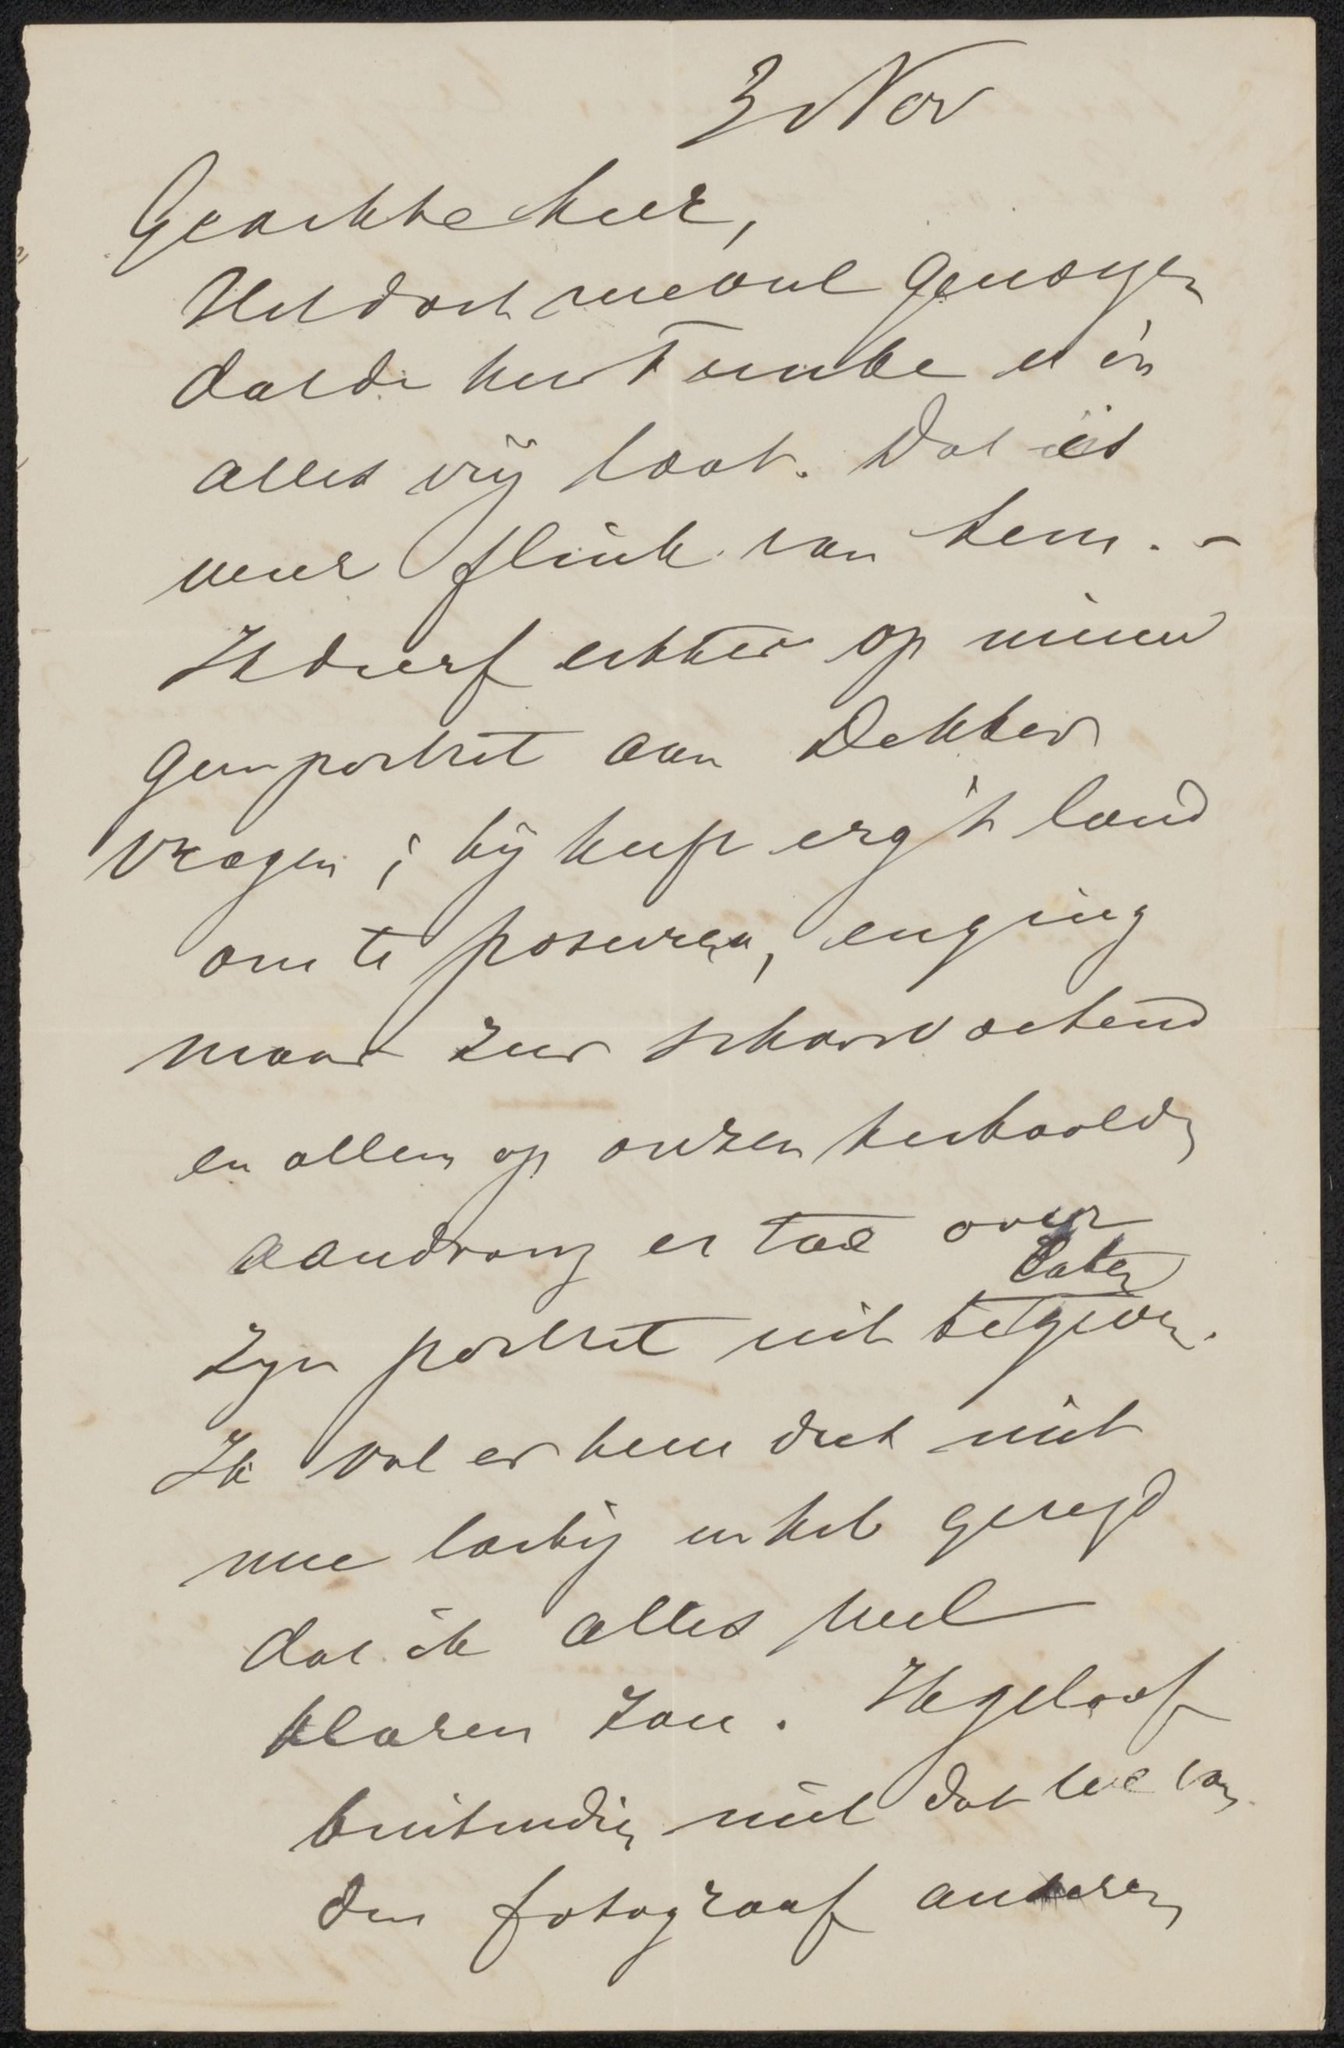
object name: letter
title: Brief aan August Allebé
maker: carel vosmaer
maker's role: draughtsman, print maker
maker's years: 1826-1888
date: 1848-1888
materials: ink, paper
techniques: pen, writing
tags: amsterdam, print maker, draughtsman, august allebé, multatuli, historical persons (portraits and scenes from the life)